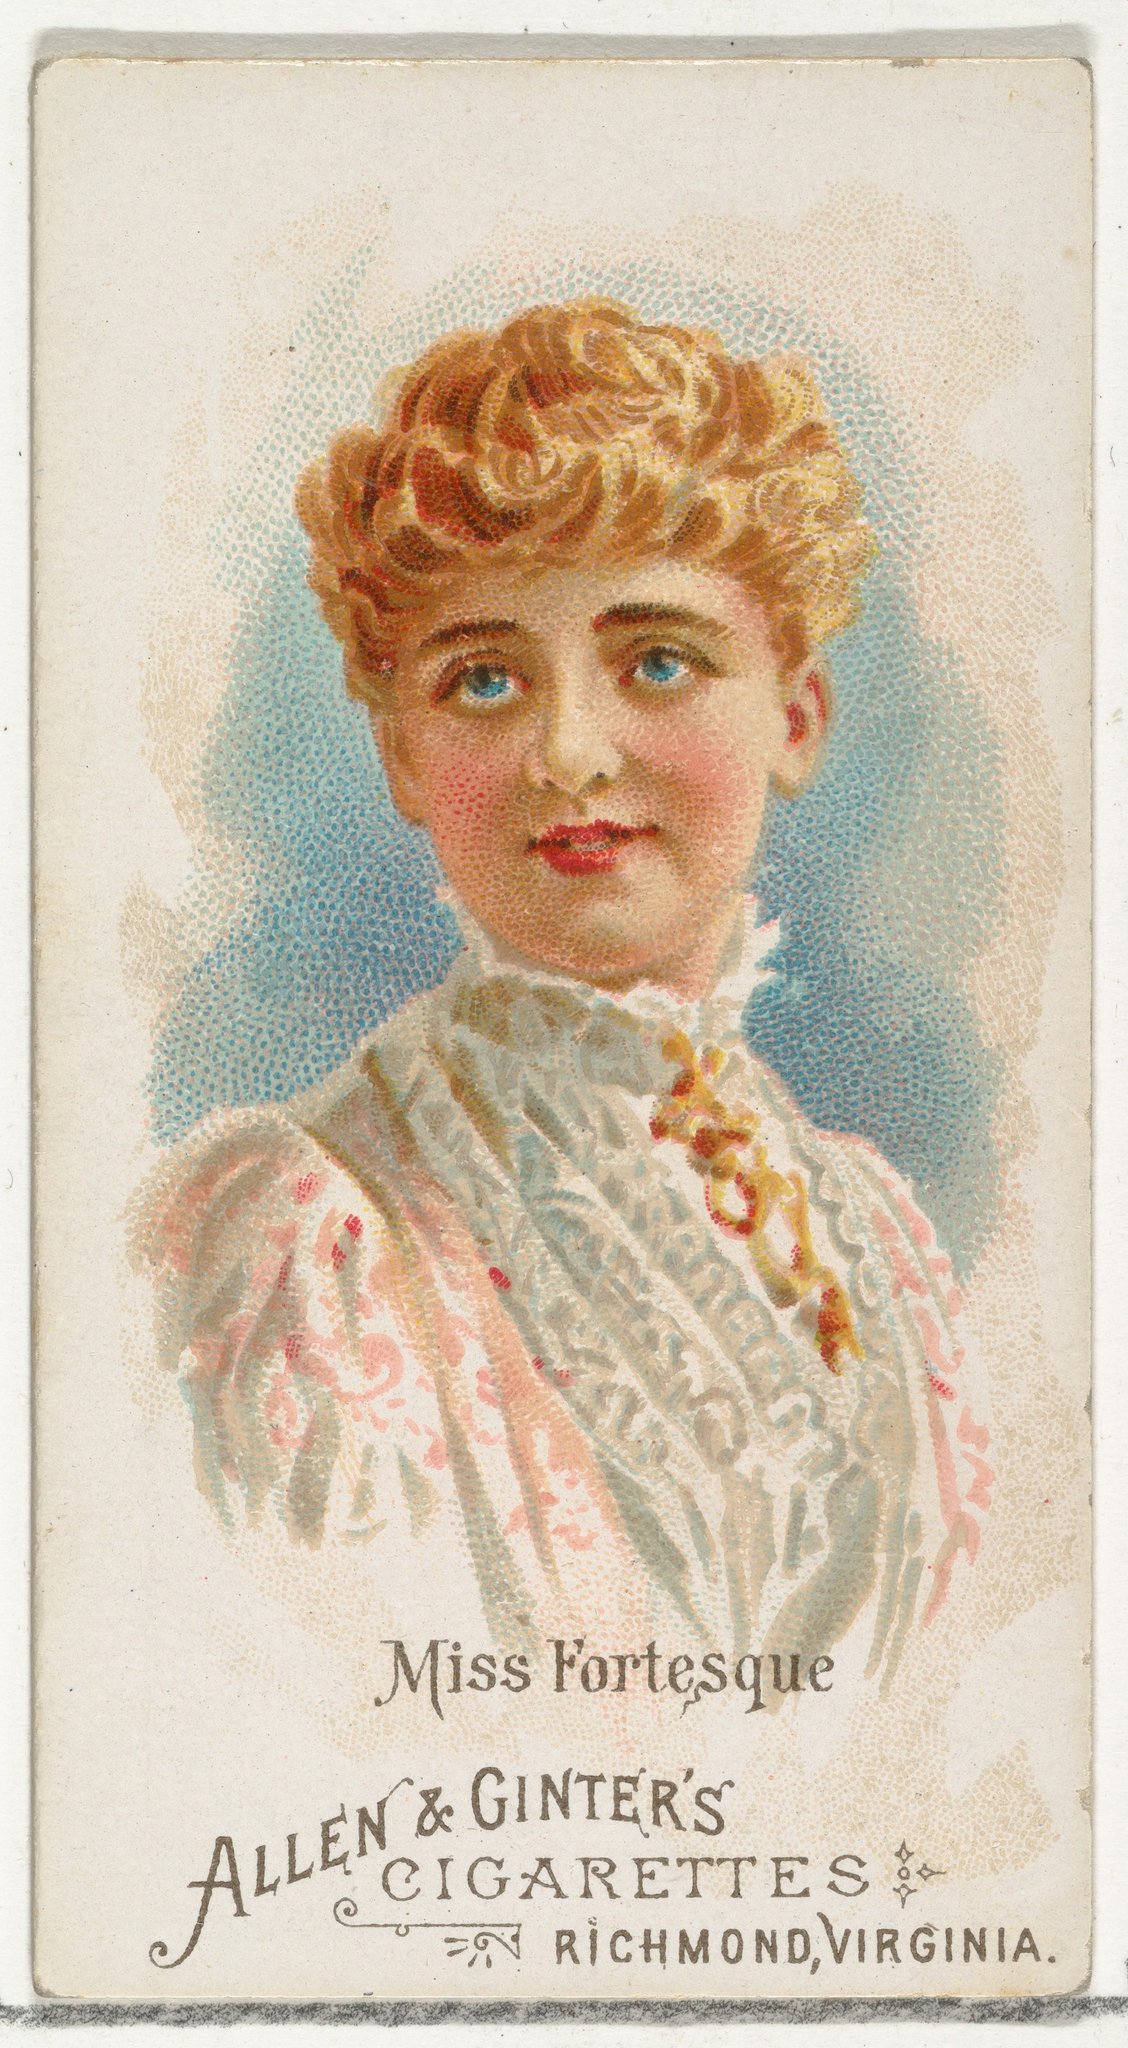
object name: print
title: Miss Fortesque, from World's Beauties, Series 1 (N26) for Allen & Ginter Cigarettes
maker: allen & ginter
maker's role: publisher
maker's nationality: american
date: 1888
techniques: color lithograph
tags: women